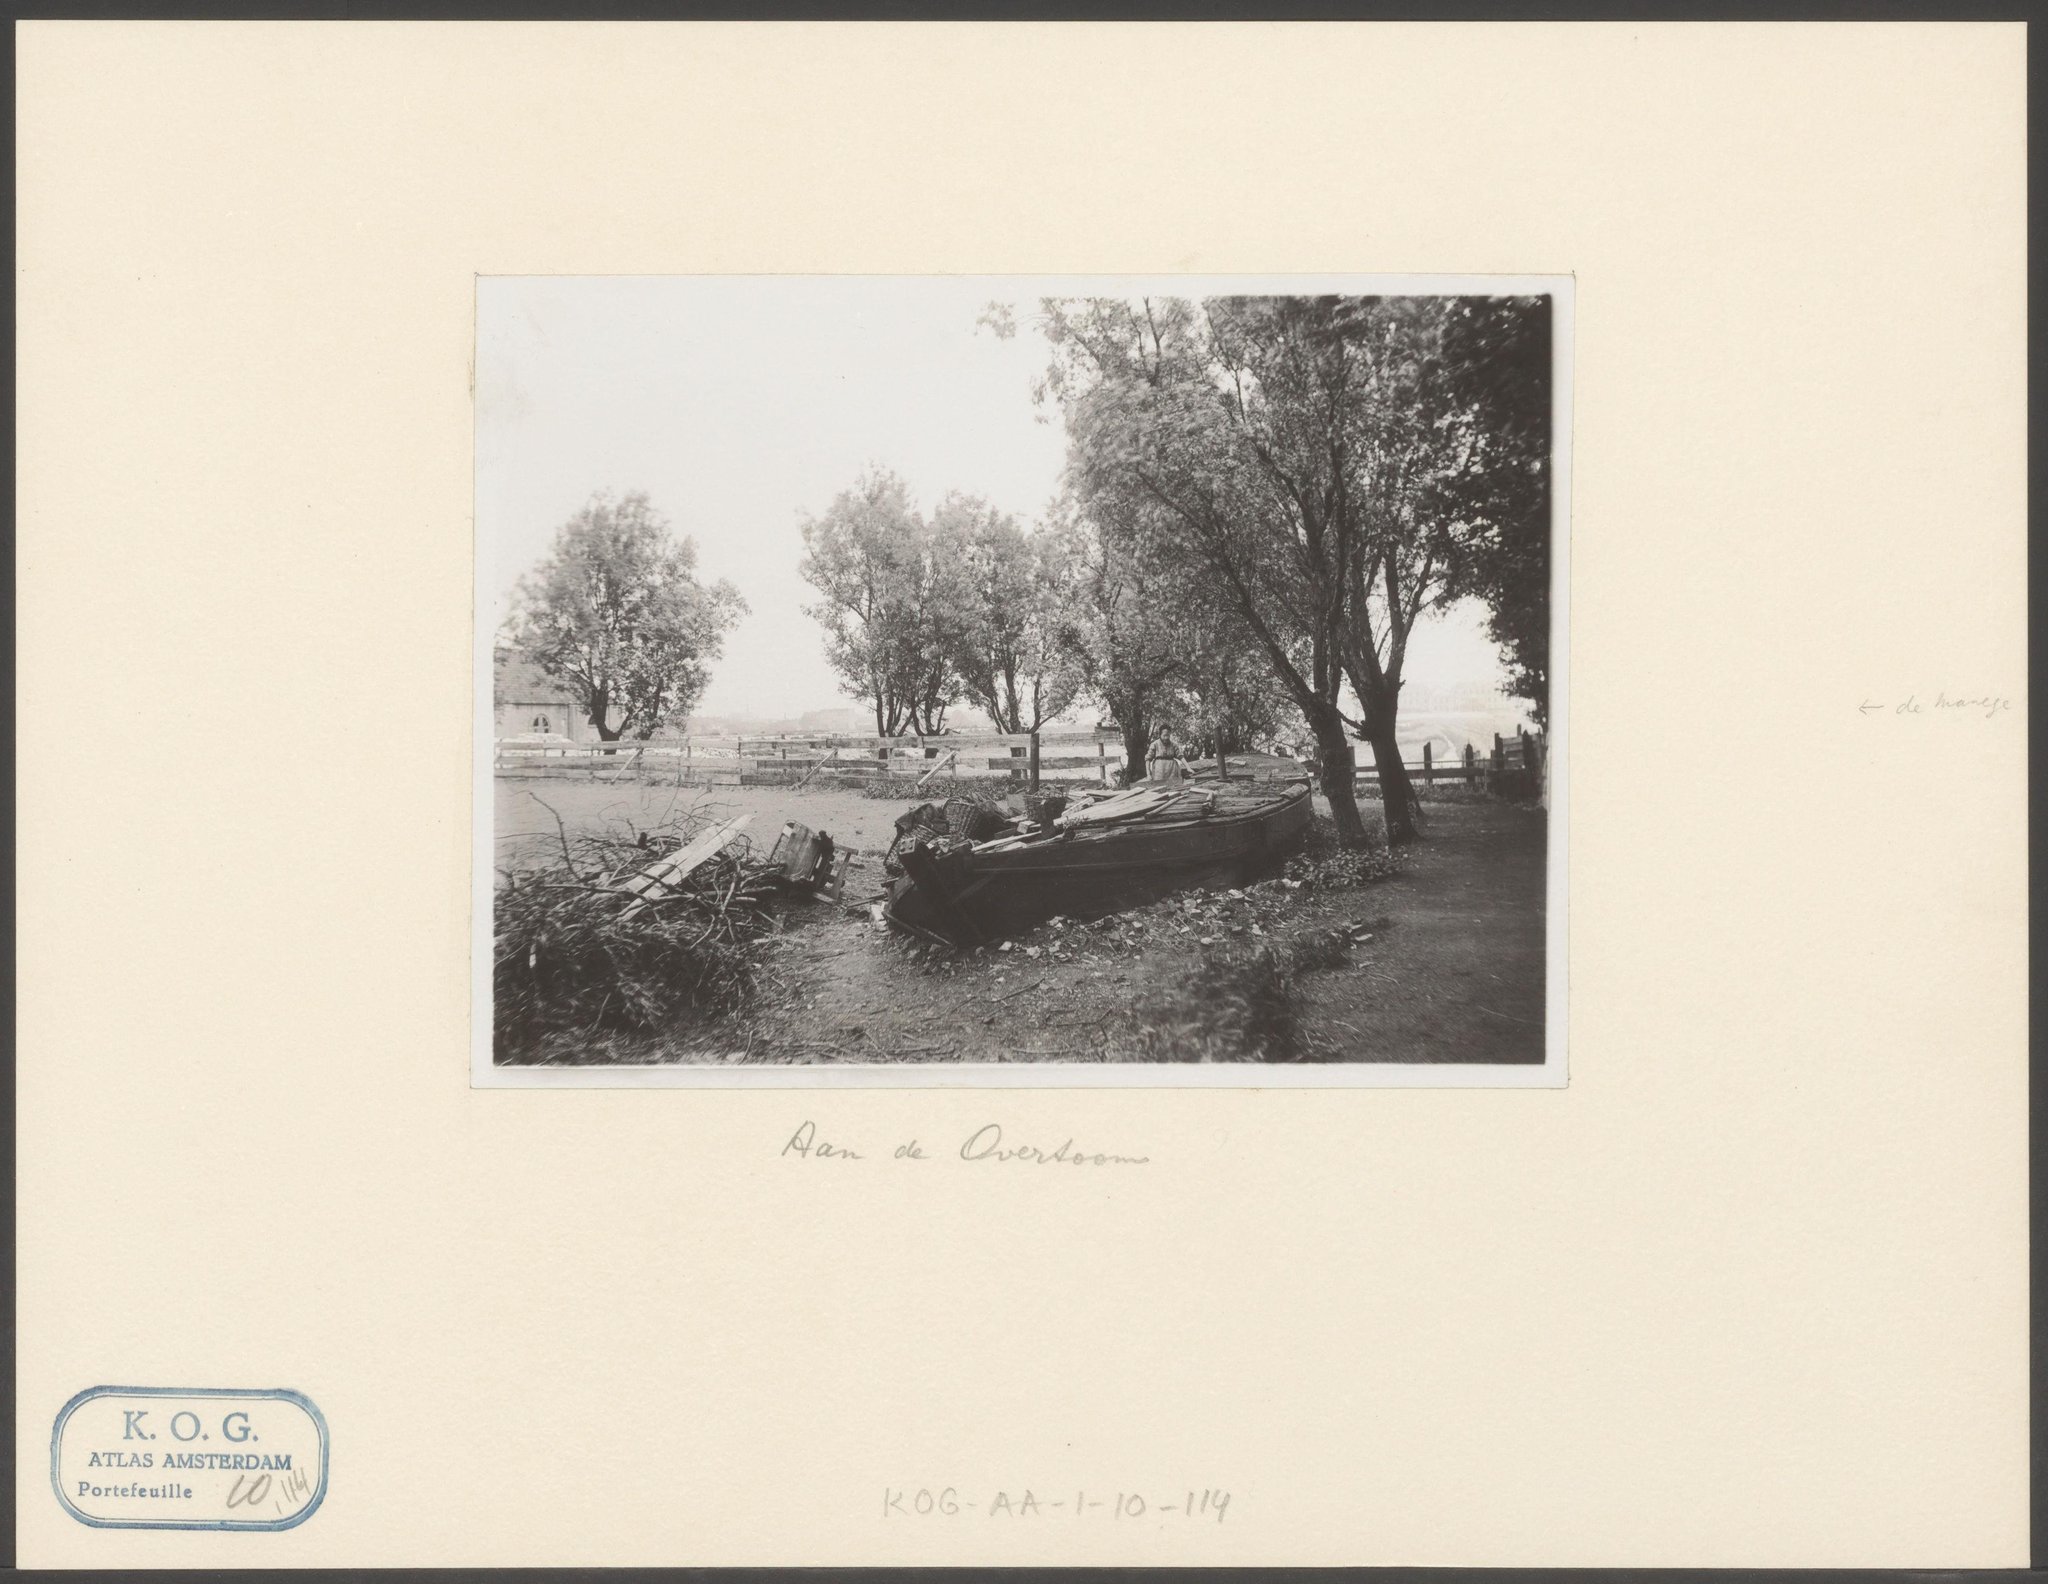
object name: photograph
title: Gezicht aan de Overtoom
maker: Anonymous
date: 1880-1950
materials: paper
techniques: gelatin silver print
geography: amsterdam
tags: city-view in general; 'veduta', tow-boat, towing-barge, farm or solitary house in landscape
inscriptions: inscription: ‘Aan de Overtoom’, collector's mark: ‘10,114’ Lugt 1641b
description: Onderwerpsrubriek binnen de Atlas Amsterdam: Overtoom.